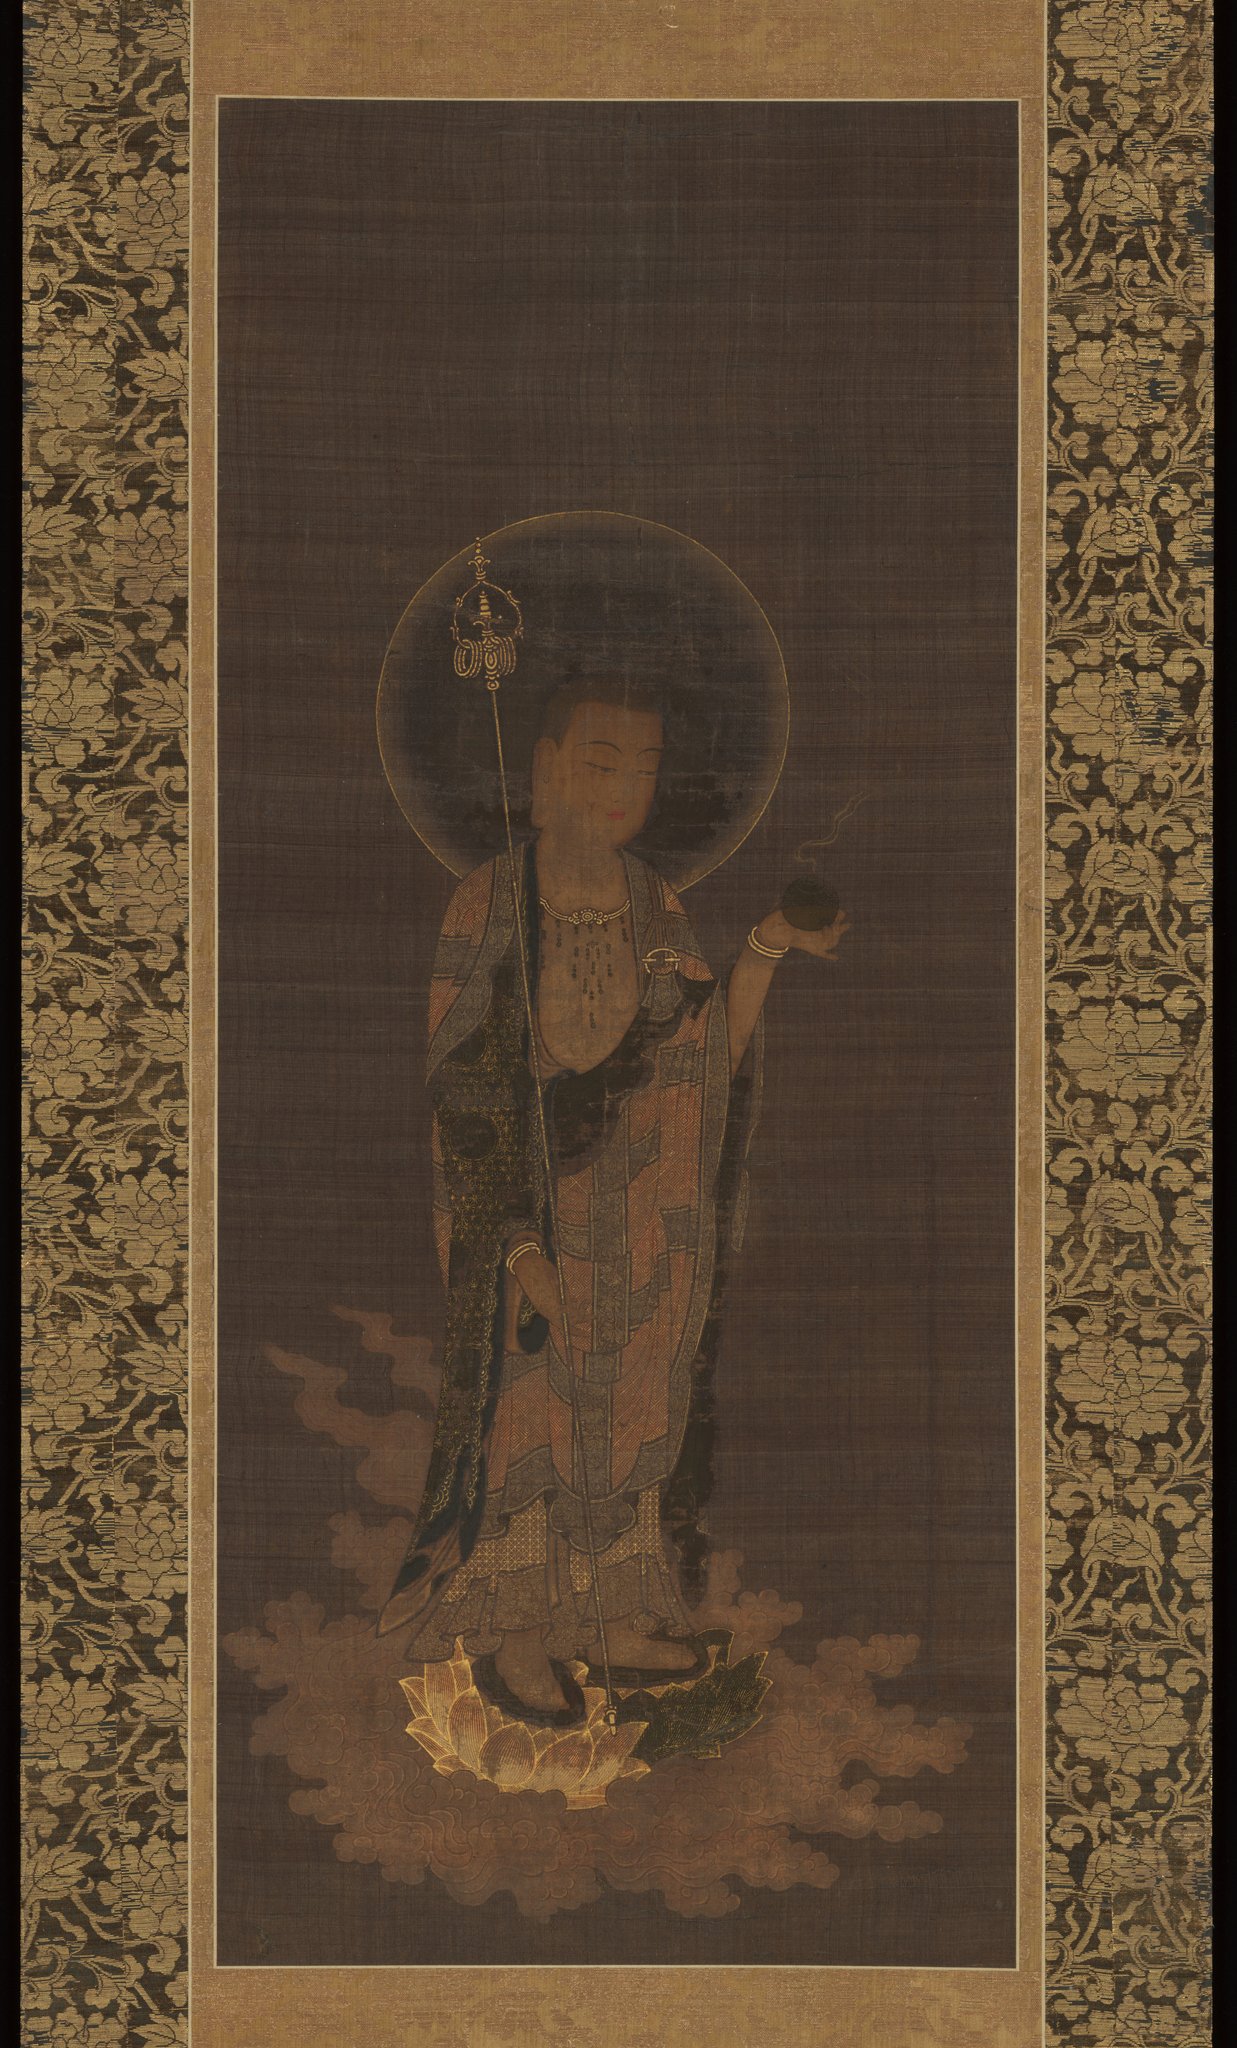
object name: hanging scroll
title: Welcoming Descent of the Bodhisattva Jizō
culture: japanese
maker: unidentified artist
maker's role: artist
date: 1301-1400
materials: gold, ink, silk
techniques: cutting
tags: bodhisattvas